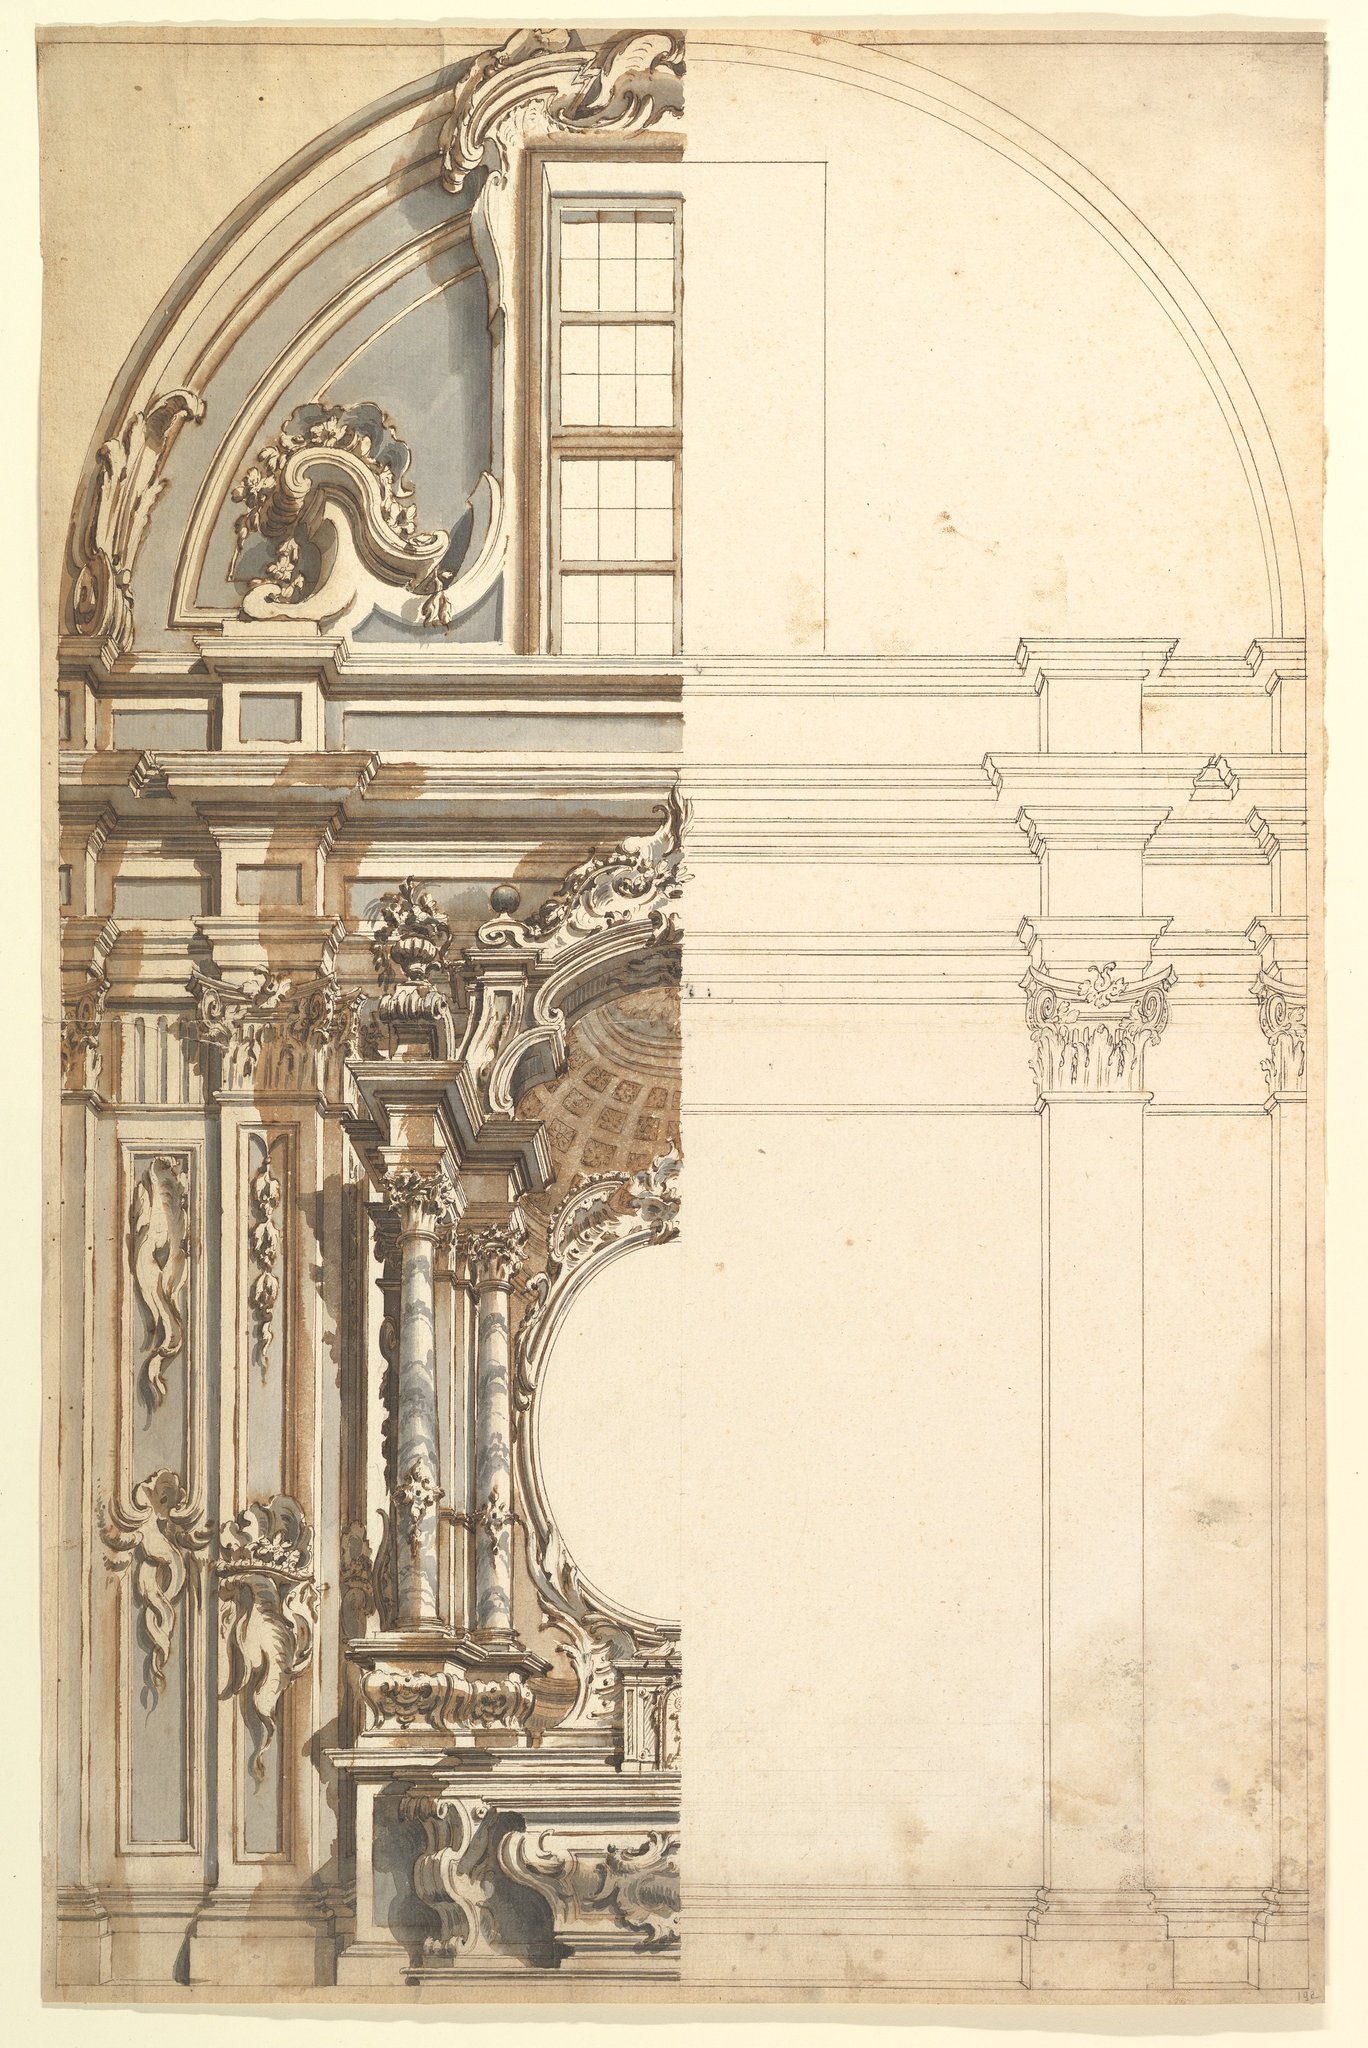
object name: drawing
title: Two Alternate Designs for a Chapel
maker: anonymous, italian, piedmontese, 18th century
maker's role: artist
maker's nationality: italian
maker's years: 1700-1800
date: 1700-1780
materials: graphite, ink, drawing material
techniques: brush, pen, wash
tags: architecture,chapels